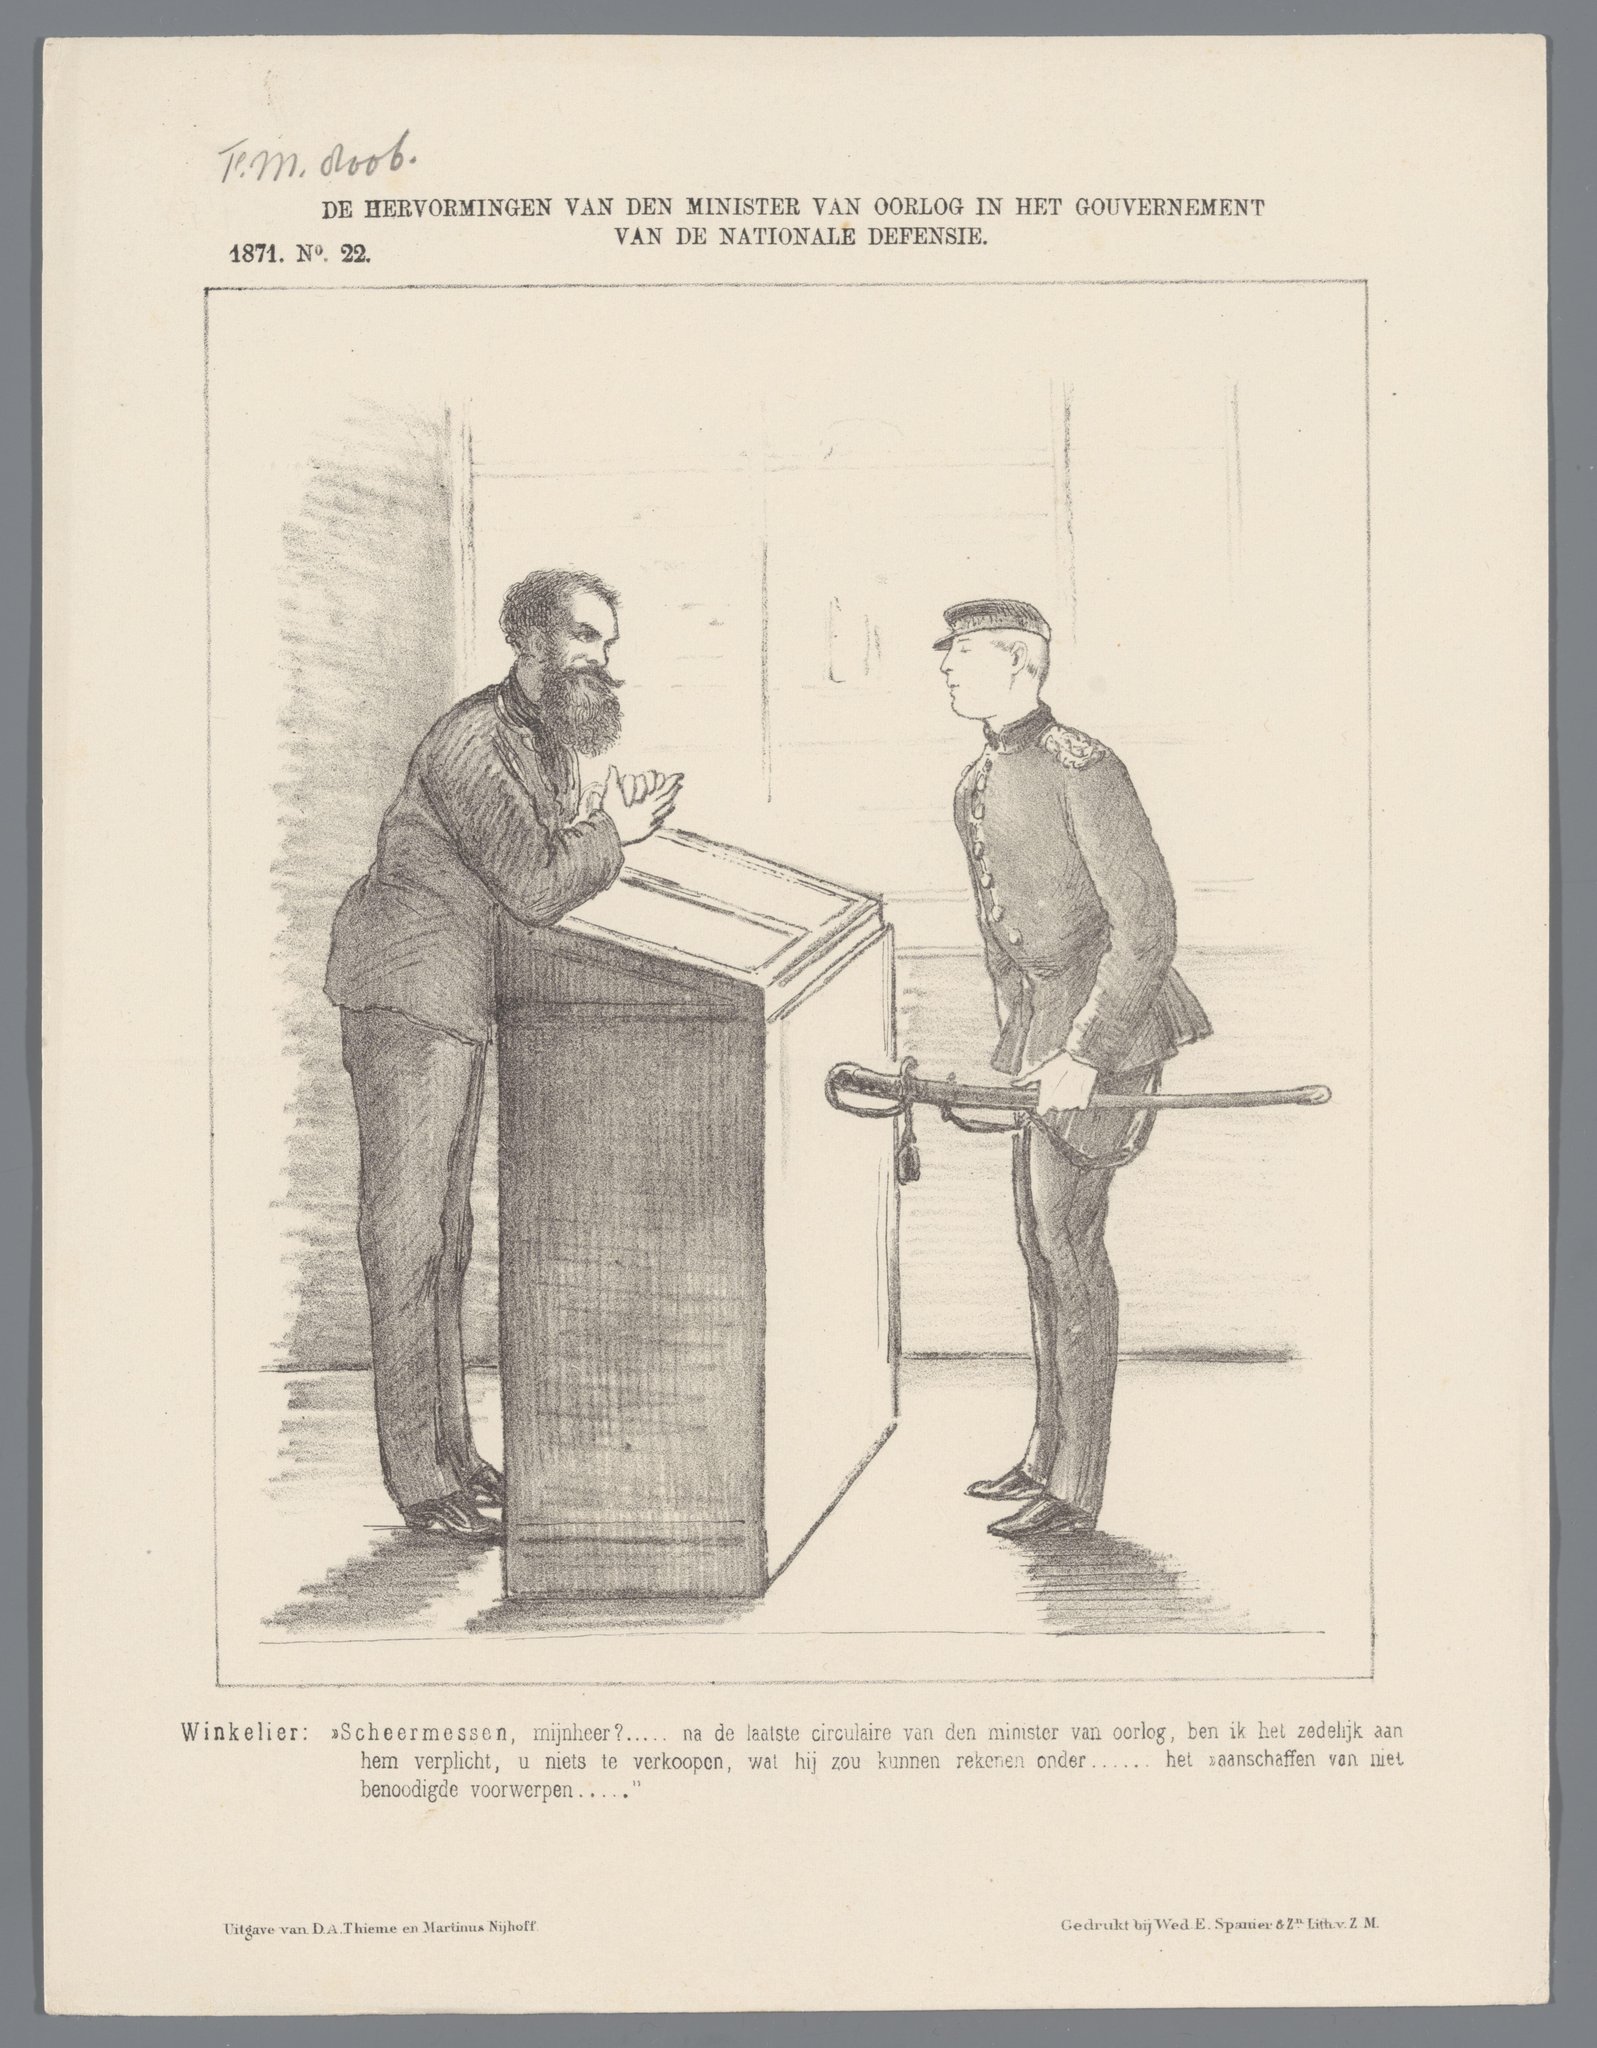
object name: print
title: Spotprent op de begroting van oorlog, 1871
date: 1871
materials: paper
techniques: lithograph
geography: arnhem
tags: shop, store, shopkeeper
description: Spotprent op de begroting van het Ministerie van Oorlog. Een winkelier weigert een kadet scheermesjes te verkopen, zich beroepend op de nieuwe regels van het ministerie. Plaat verschenen bij het weekblad De Nederlandsche Spectator, nr. 22, 1871.